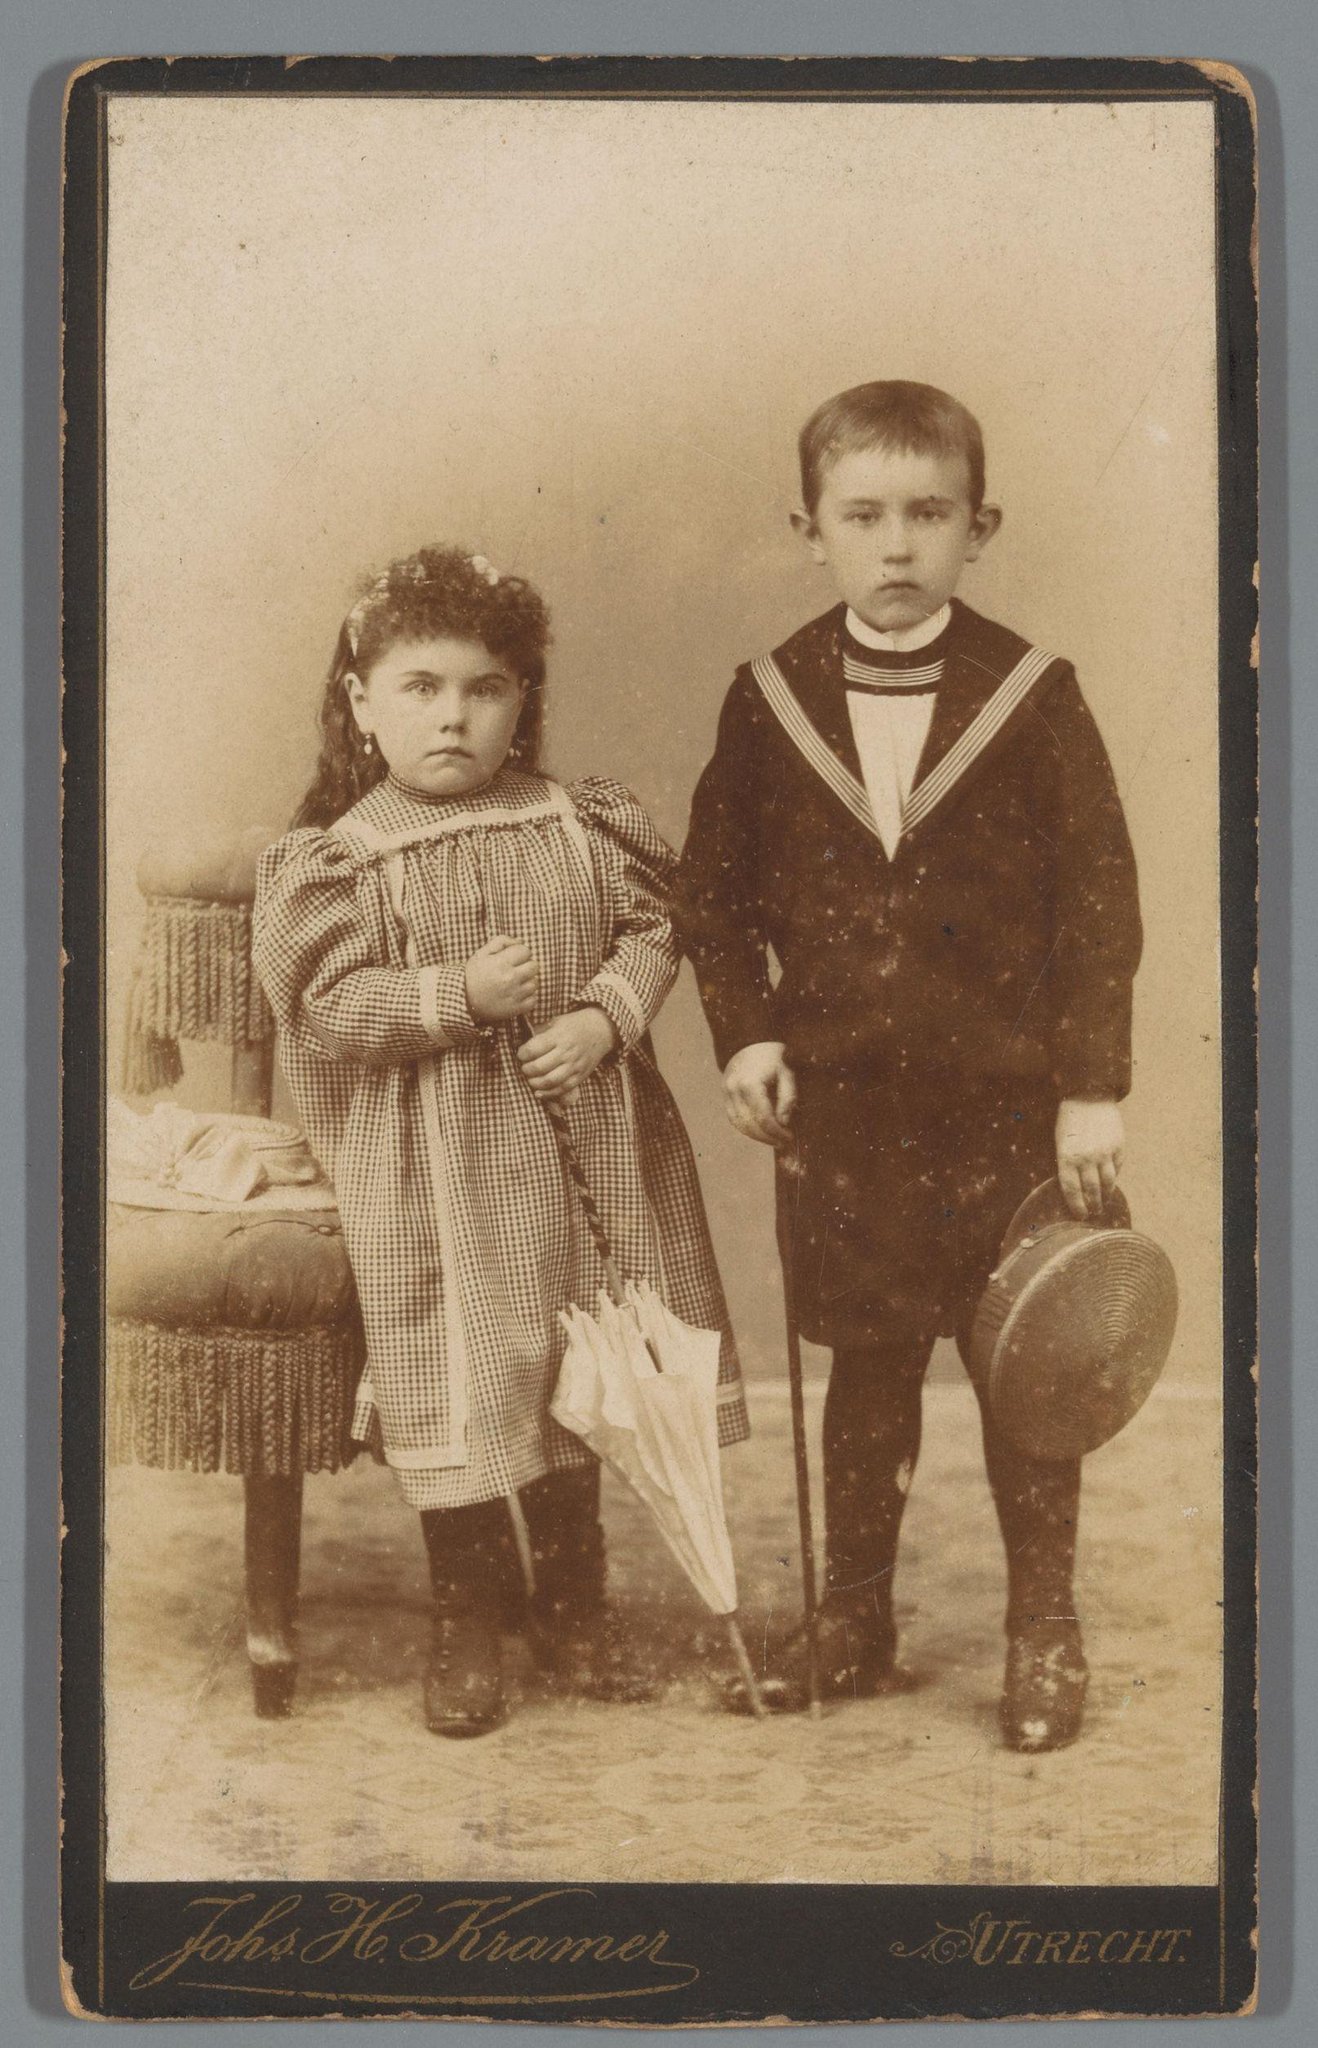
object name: photograph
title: Portret van twee onbekende kinderen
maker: johannes hendrikus kramer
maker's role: fotograaf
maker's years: 1846-1901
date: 1886-1901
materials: paper, cardboard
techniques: collodion silver print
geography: utrecht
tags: child, historical persons not known by name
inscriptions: inscription: ‘Photographisch/ Atelier (...) Inrichting voor vergrootingen.’